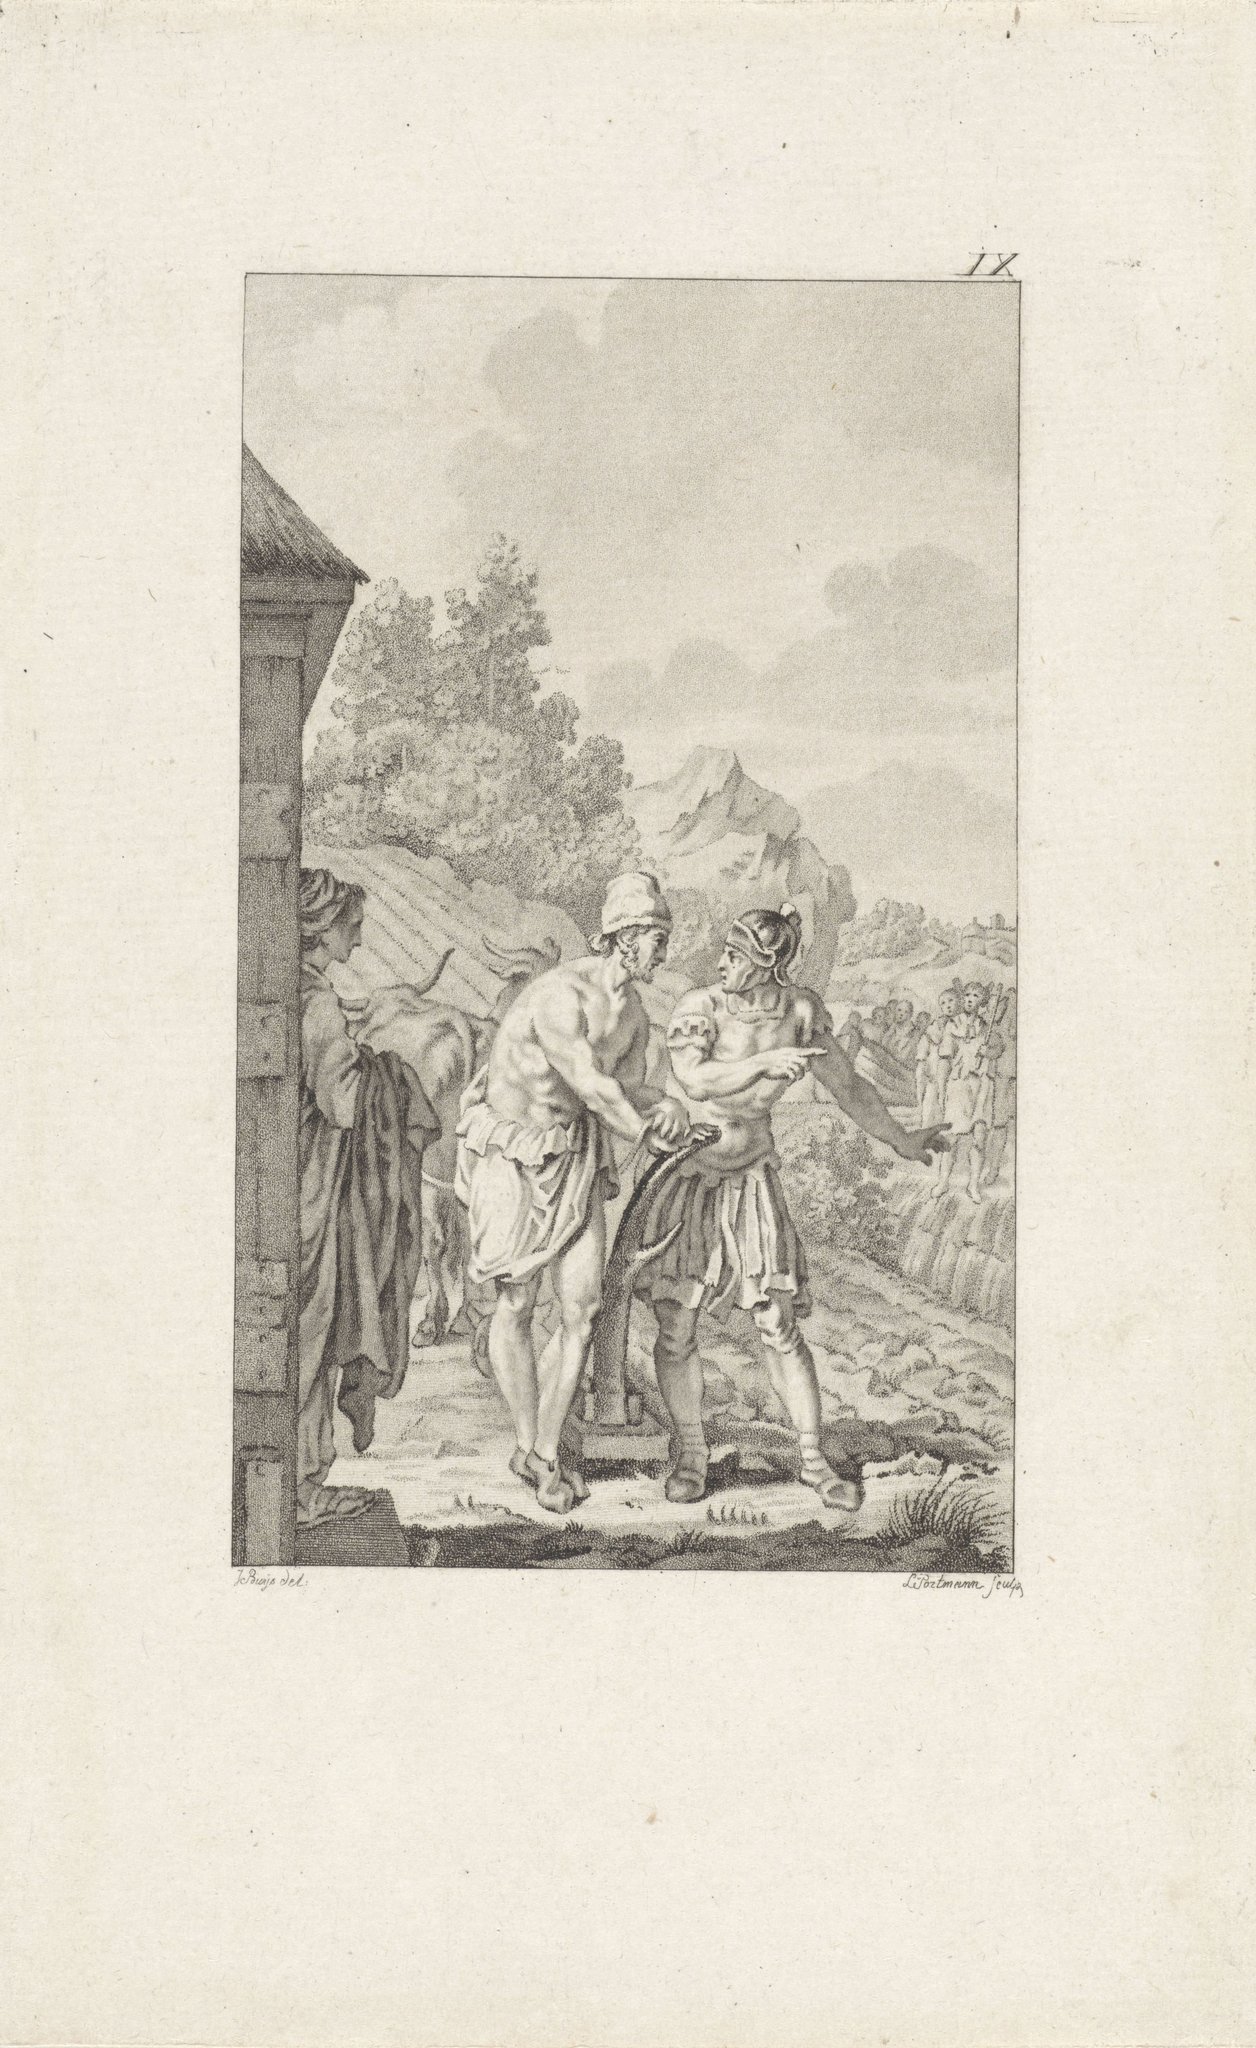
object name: print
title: Lucius Quinctius Cincinnatus gevraagd als dictator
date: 1793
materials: paper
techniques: etching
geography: utrecht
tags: lucius quinctius cincinnatus is called from the plough to the dictatorship of rome; a roman embassy offers him a sword or a baton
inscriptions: collector's mark: Lugt 2228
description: De Romeinse veldheer Lucius Quinctius Cincinnatus wordt tot dictator benoemd. Een soldaat laat hem kiezen tussen het zwaard en een ploeg. Uiteindelijk wint hij de oorlog met de Aequi al na zestien dagen, om meteen weer zijn velden te gaan ploegen.